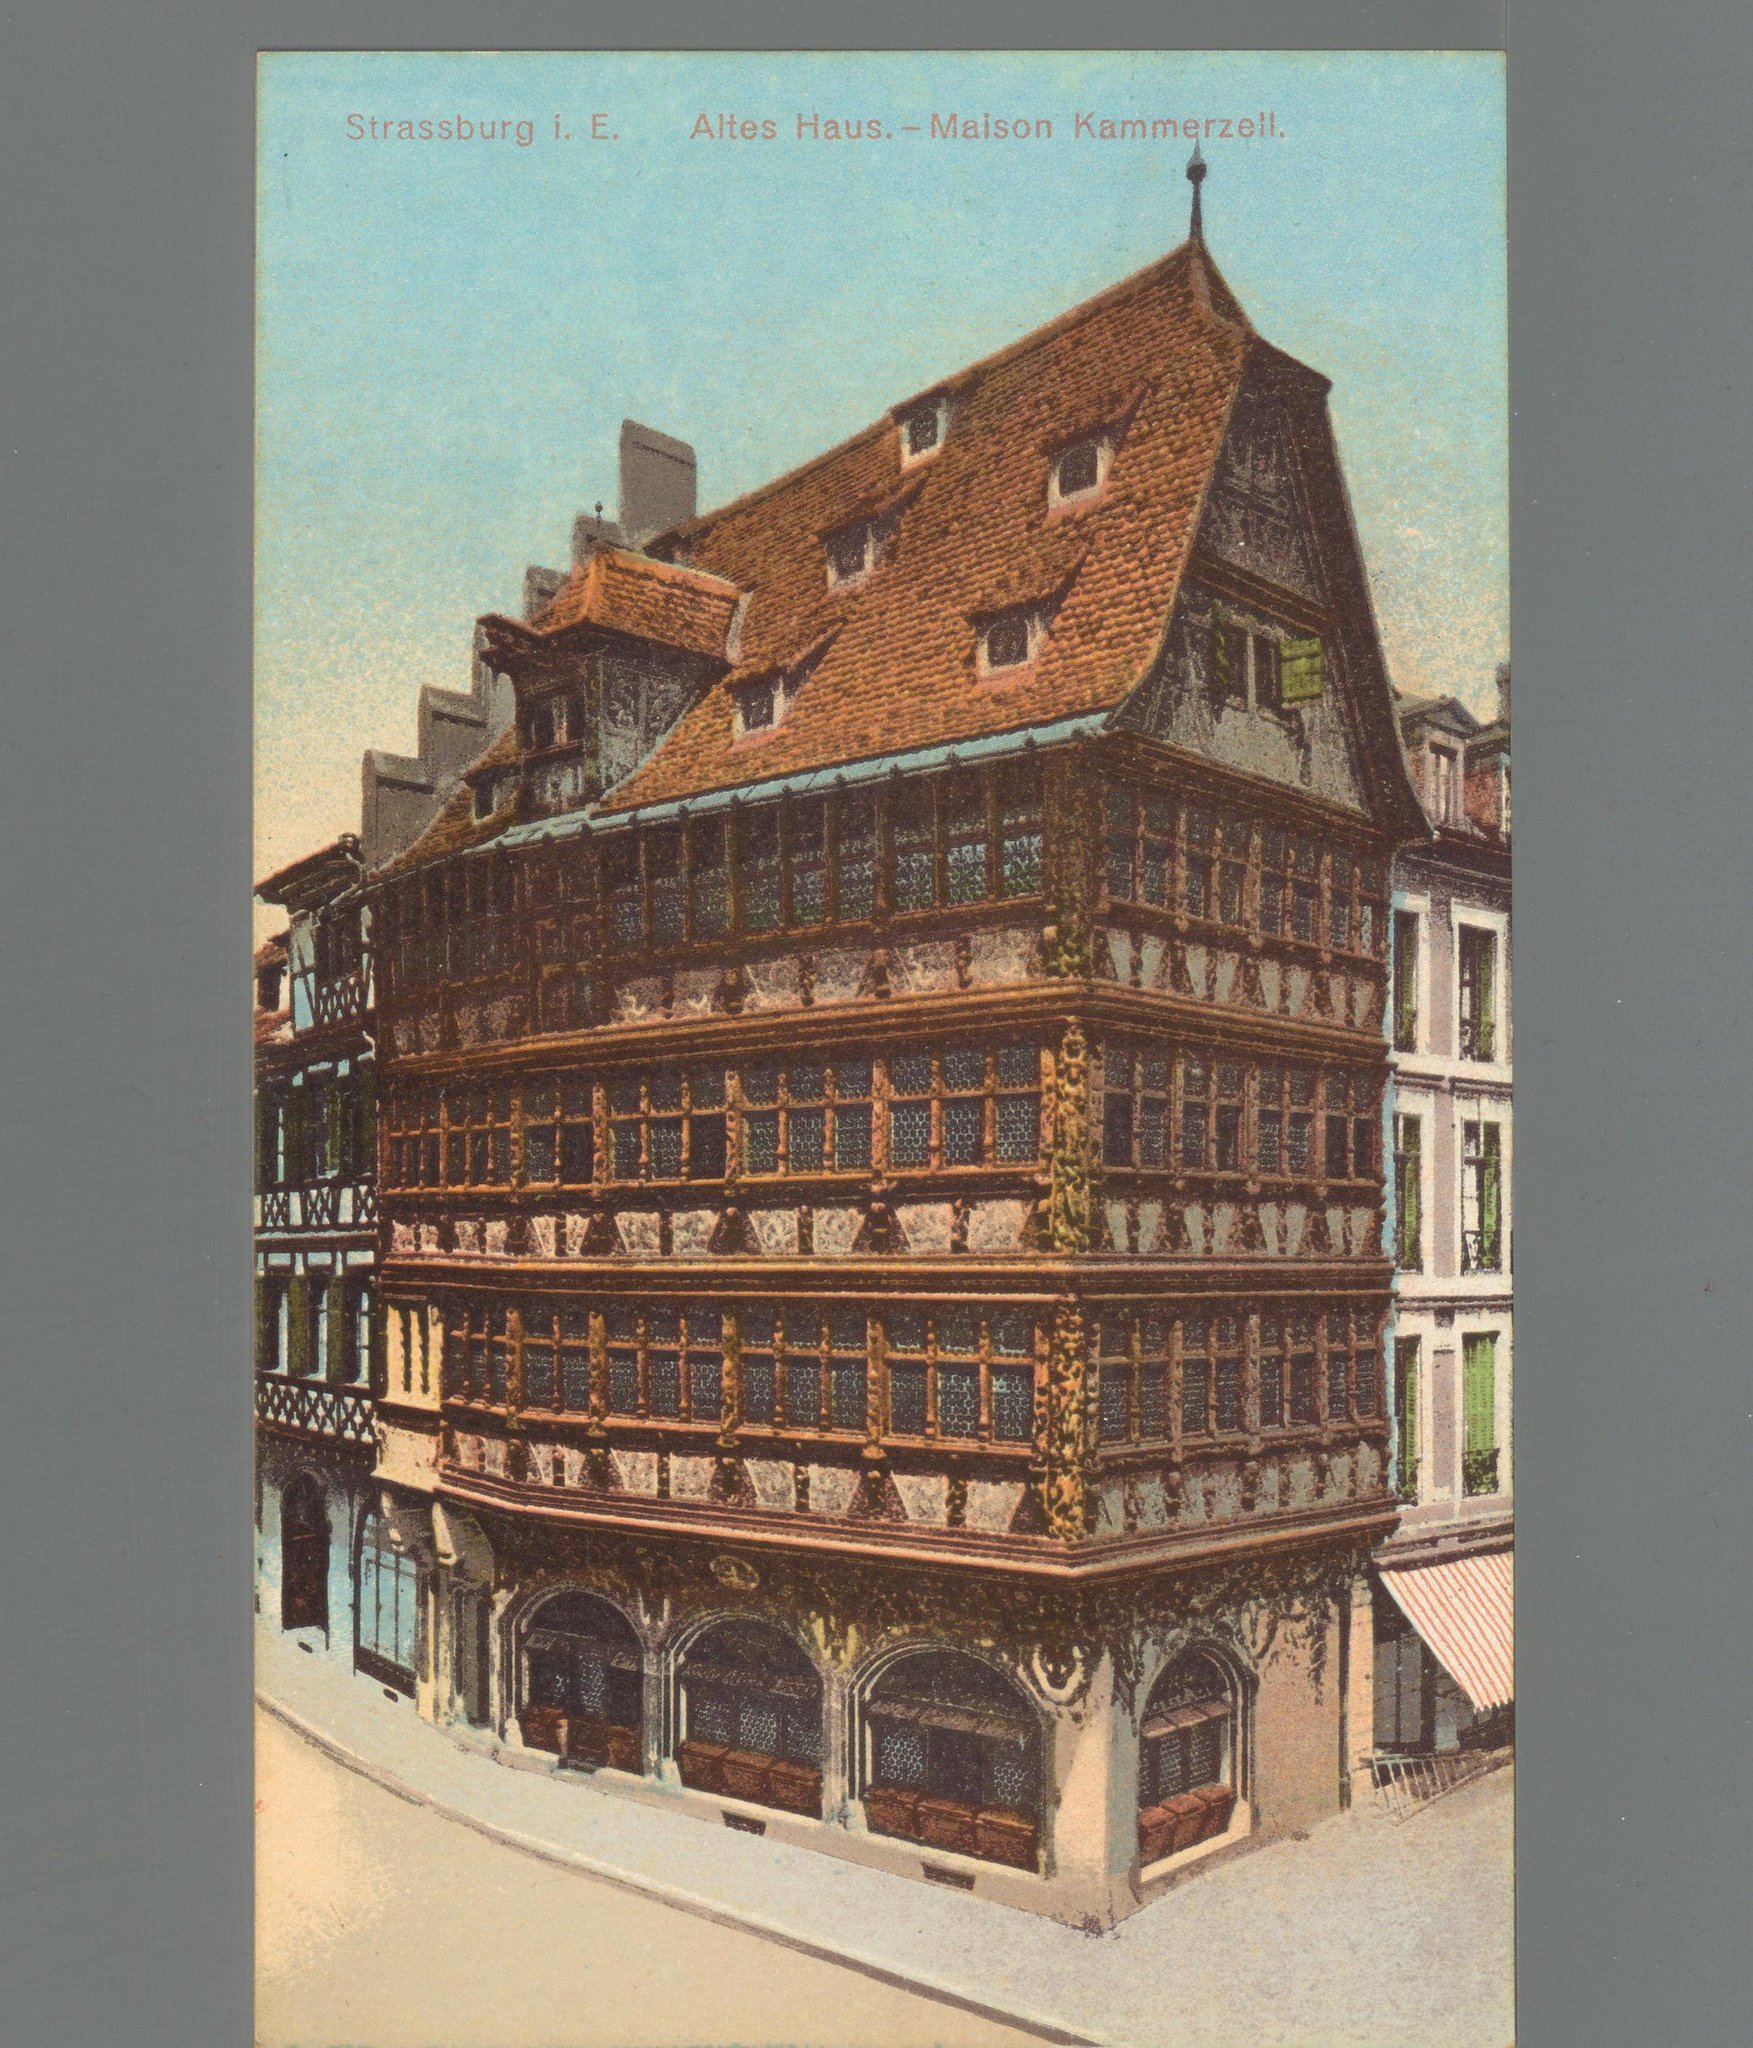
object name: print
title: Strassburg i. E. Altes Haus / Maison Kammerzell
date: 1905-1930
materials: cardboard, photographic process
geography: straatsburg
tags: urban housing